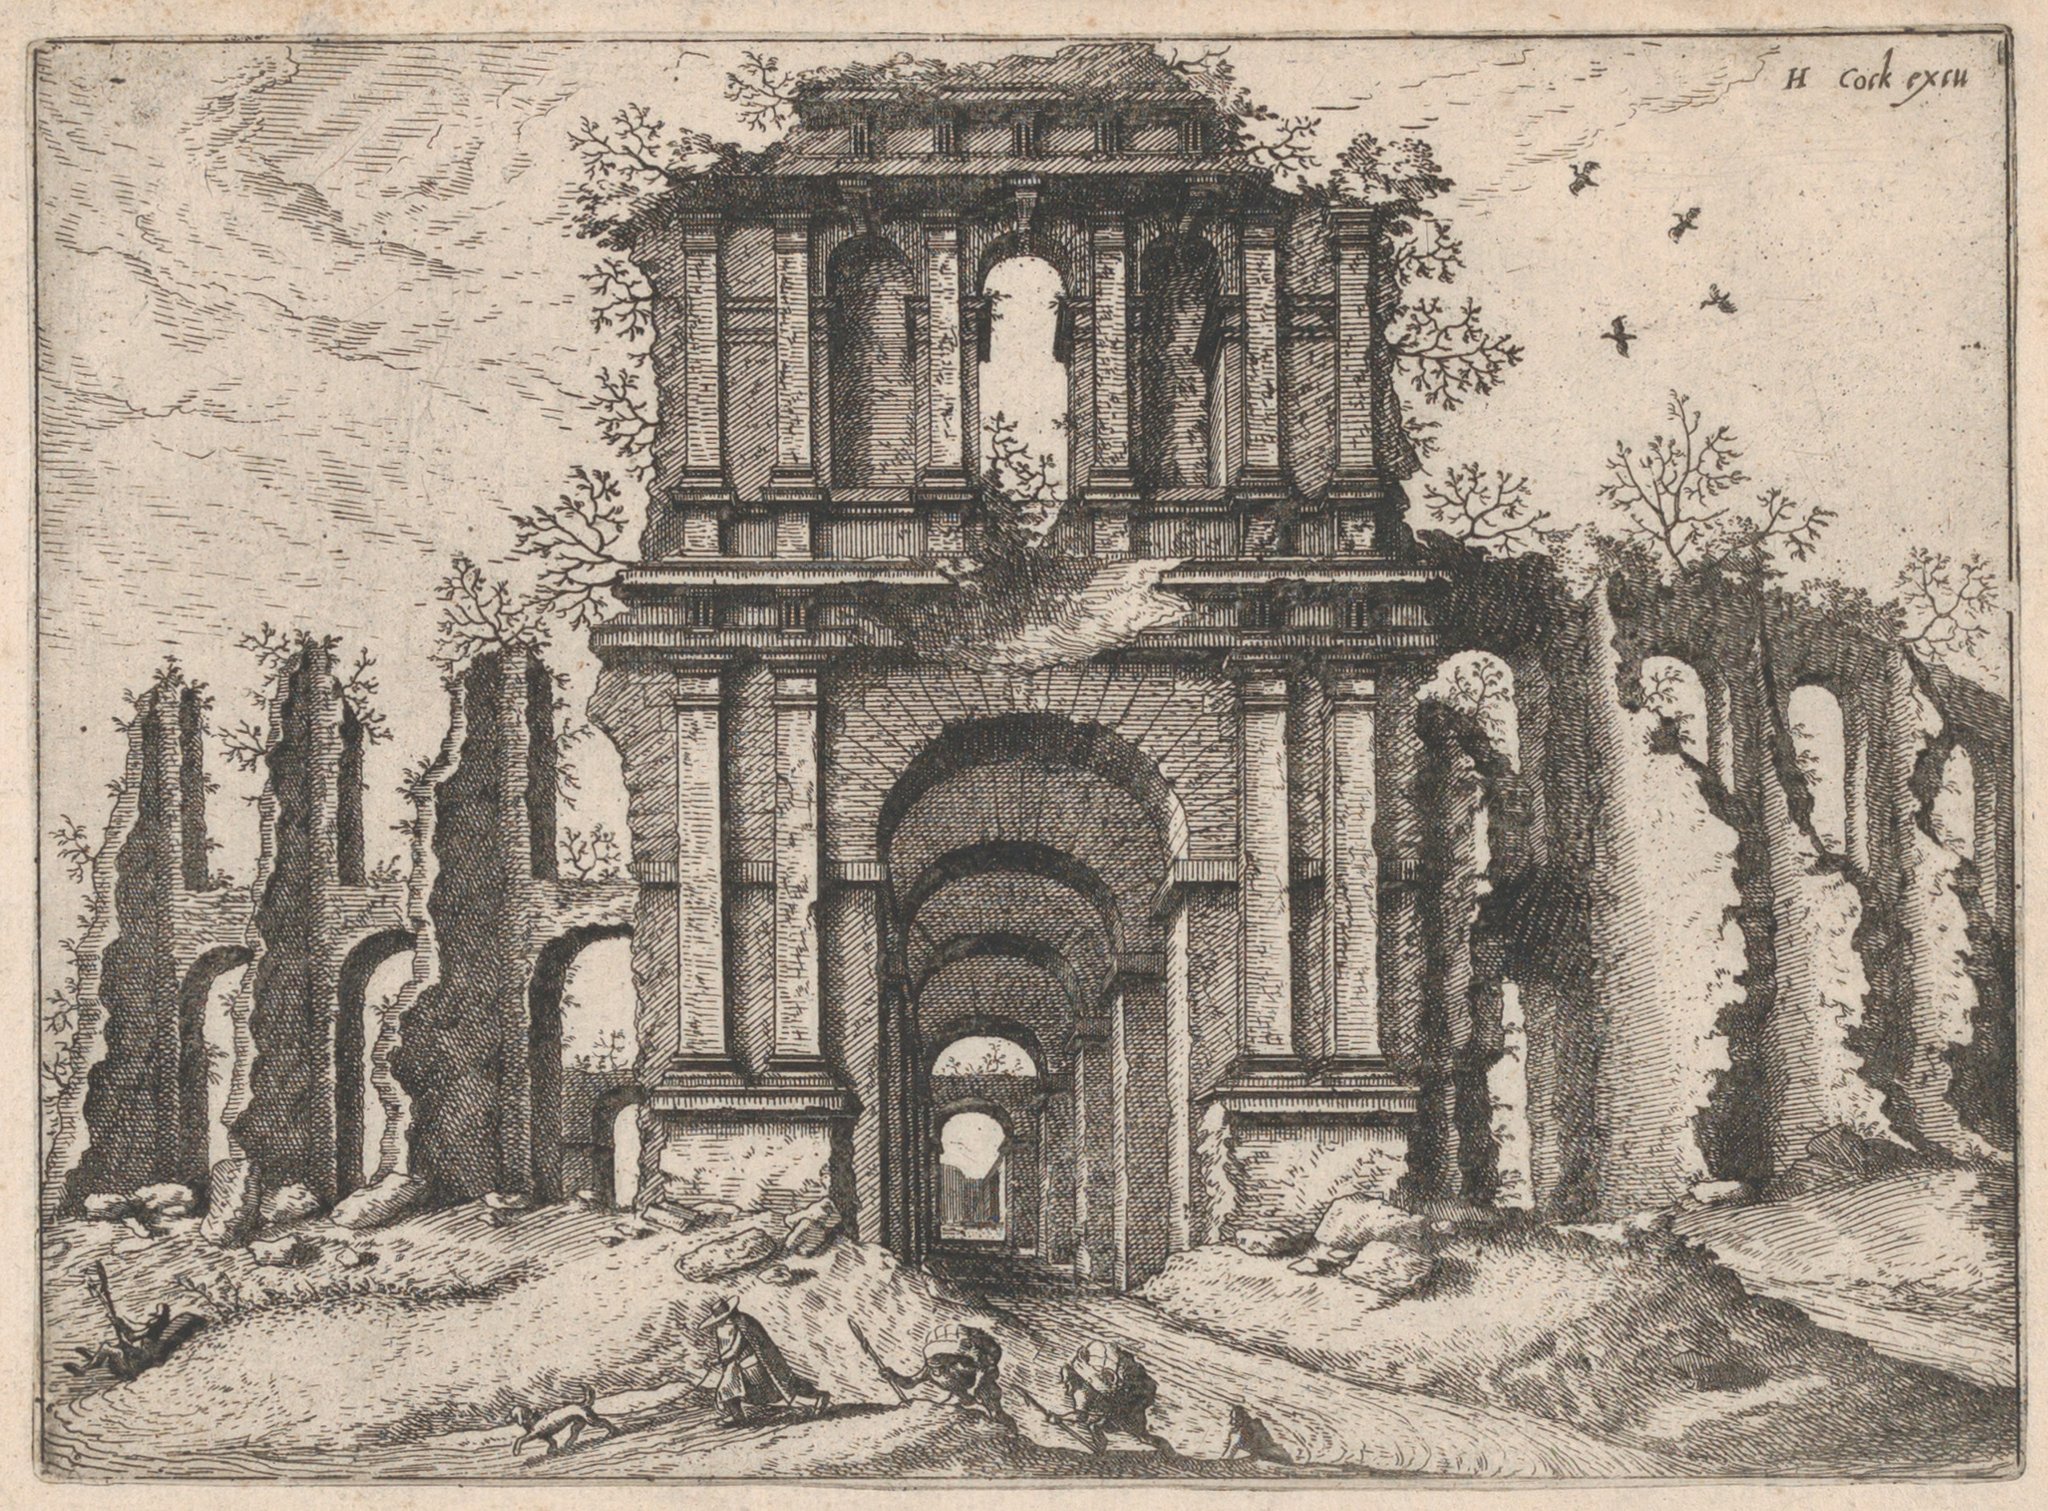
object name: print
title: Two Story Entrance Flanked by Coupled Pilasters, from "Roman Ruins and Buildings"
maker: johannes van doetecum i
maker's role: artist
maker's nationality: netherlandish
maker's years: 1528-1605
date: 1562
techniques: engraving, etching